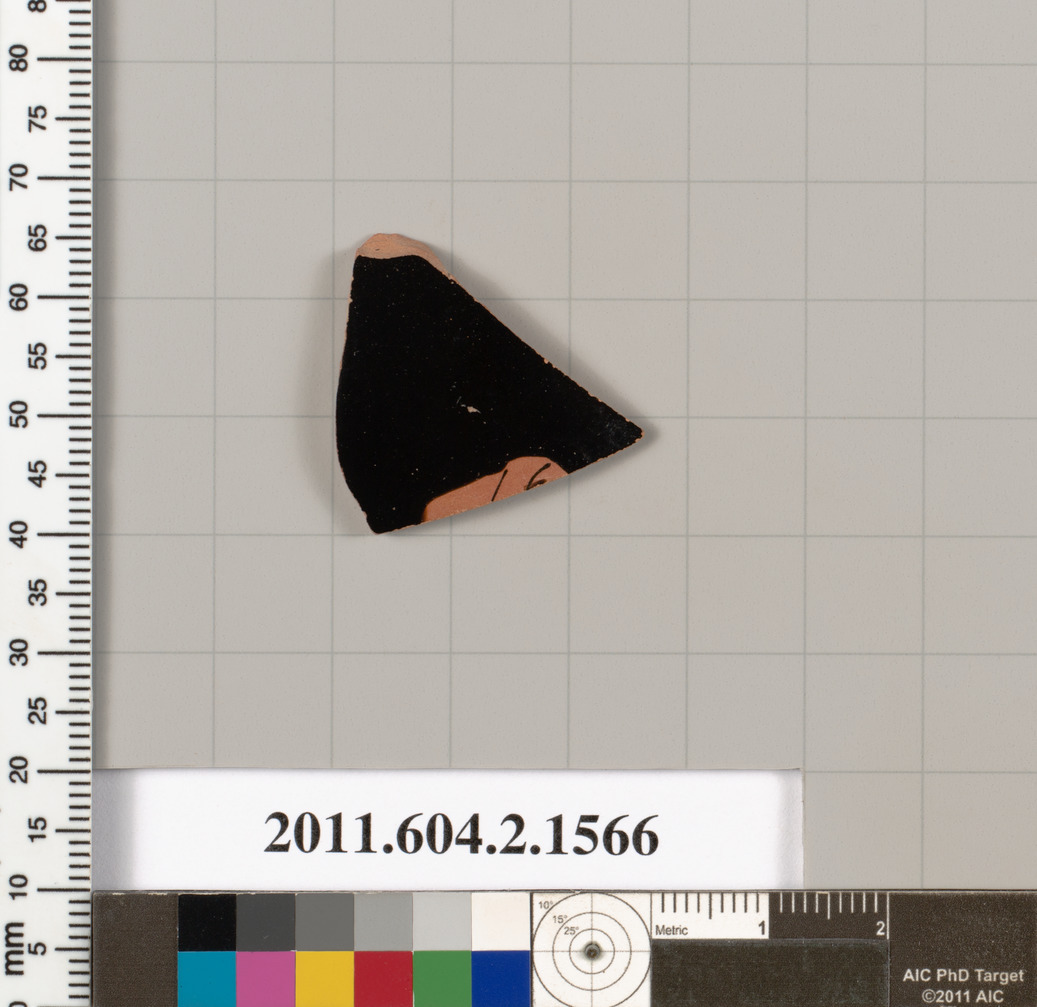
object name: skyphos fragment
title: Terracotta fragment of a skyphos (deep drinking cup)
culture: greek, attic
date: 460-440 BCE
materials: terracotta